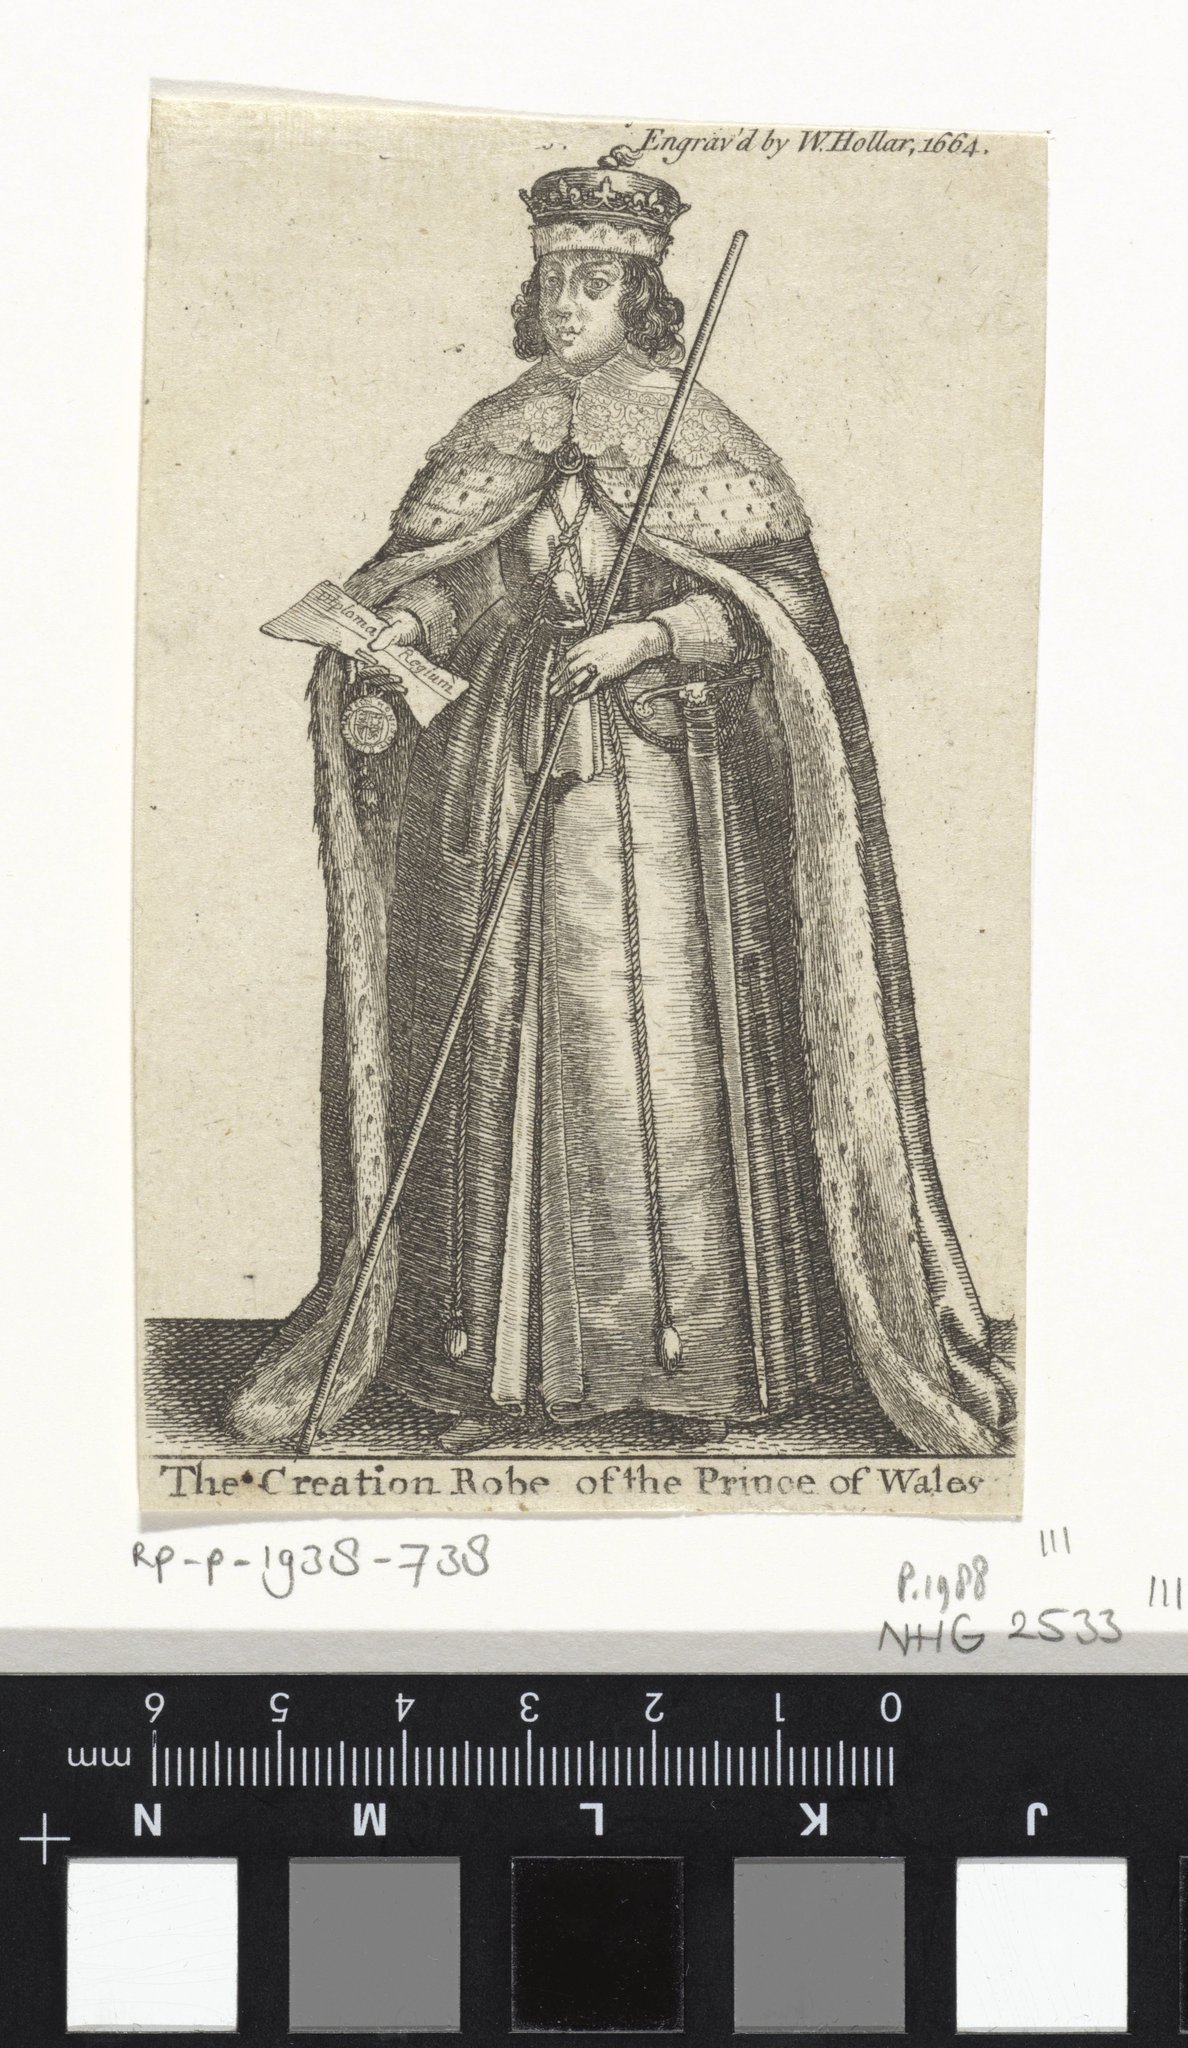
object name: print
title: Karel Stuart, prins van Wales, in ceremoniële kledij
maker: wenceslaus hollar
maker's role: draughtsman, print maker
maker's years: 1607-1677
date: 1617-1677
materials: paper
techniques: etching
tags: london, karel i (koning van engeland), clothes for special purposes, nobility and patriciate; chivalry, knighthood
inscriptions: collector's mark: Lugt 789a, collector's mark: Lugt 2228, collector's mark: Lugt 2228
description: De prent maakt deel uit van een negendelige serie met ceremoniële kledij van de Engelse adel. De eerste staat werd als onderdeel van bovengenoemde serie mogelijk door Thomas Jenner opgenomen onder de titel 'The Creation Robes of the Nobility in 9-Plates' in zijn 'A Catalogue of Severall Bookes', 1662. De genummerde staten werden later door John Bowles uitgegeven onder de titel 'Hollar's Habits, or the Nobility in their Creation', ca. 1732. Hollar werkte naar ontwerpen uit Richard Glover's 'Nobilitas politica vel civilis', Londen, 1608.